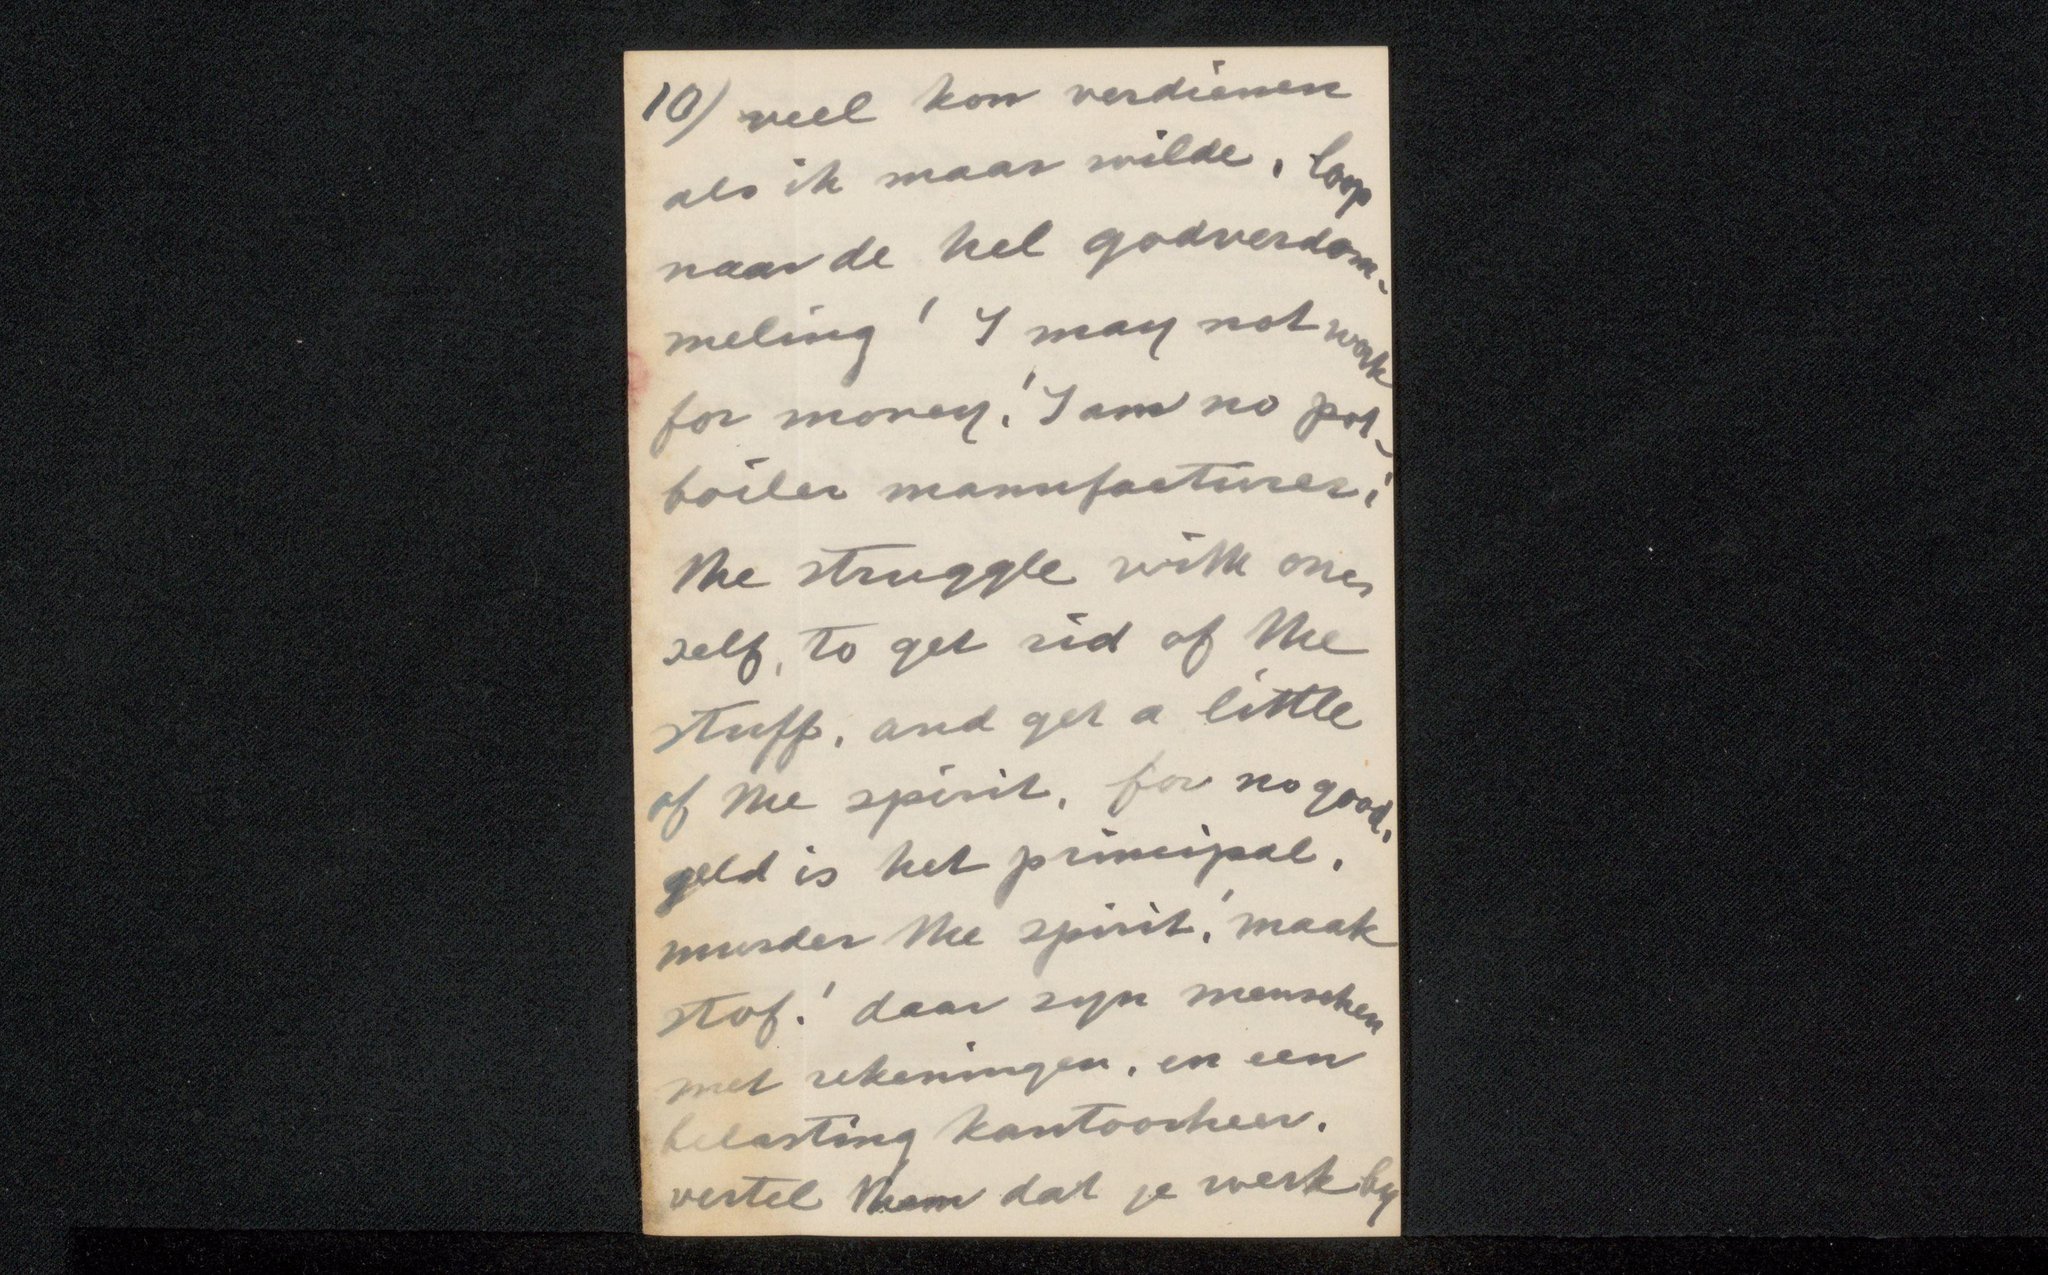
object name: letter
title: Brief aan Philip Zilcken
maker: matthijs maris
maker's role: draughtsman, painter, print maker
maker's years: 1839-1917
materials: ink, paper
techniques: pen, writing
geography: london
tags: the hague, painter, draughtsman, philip zilcken, painting (including book-illumination, miniature-painting), money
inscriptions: collector's mark: ‘RPK’